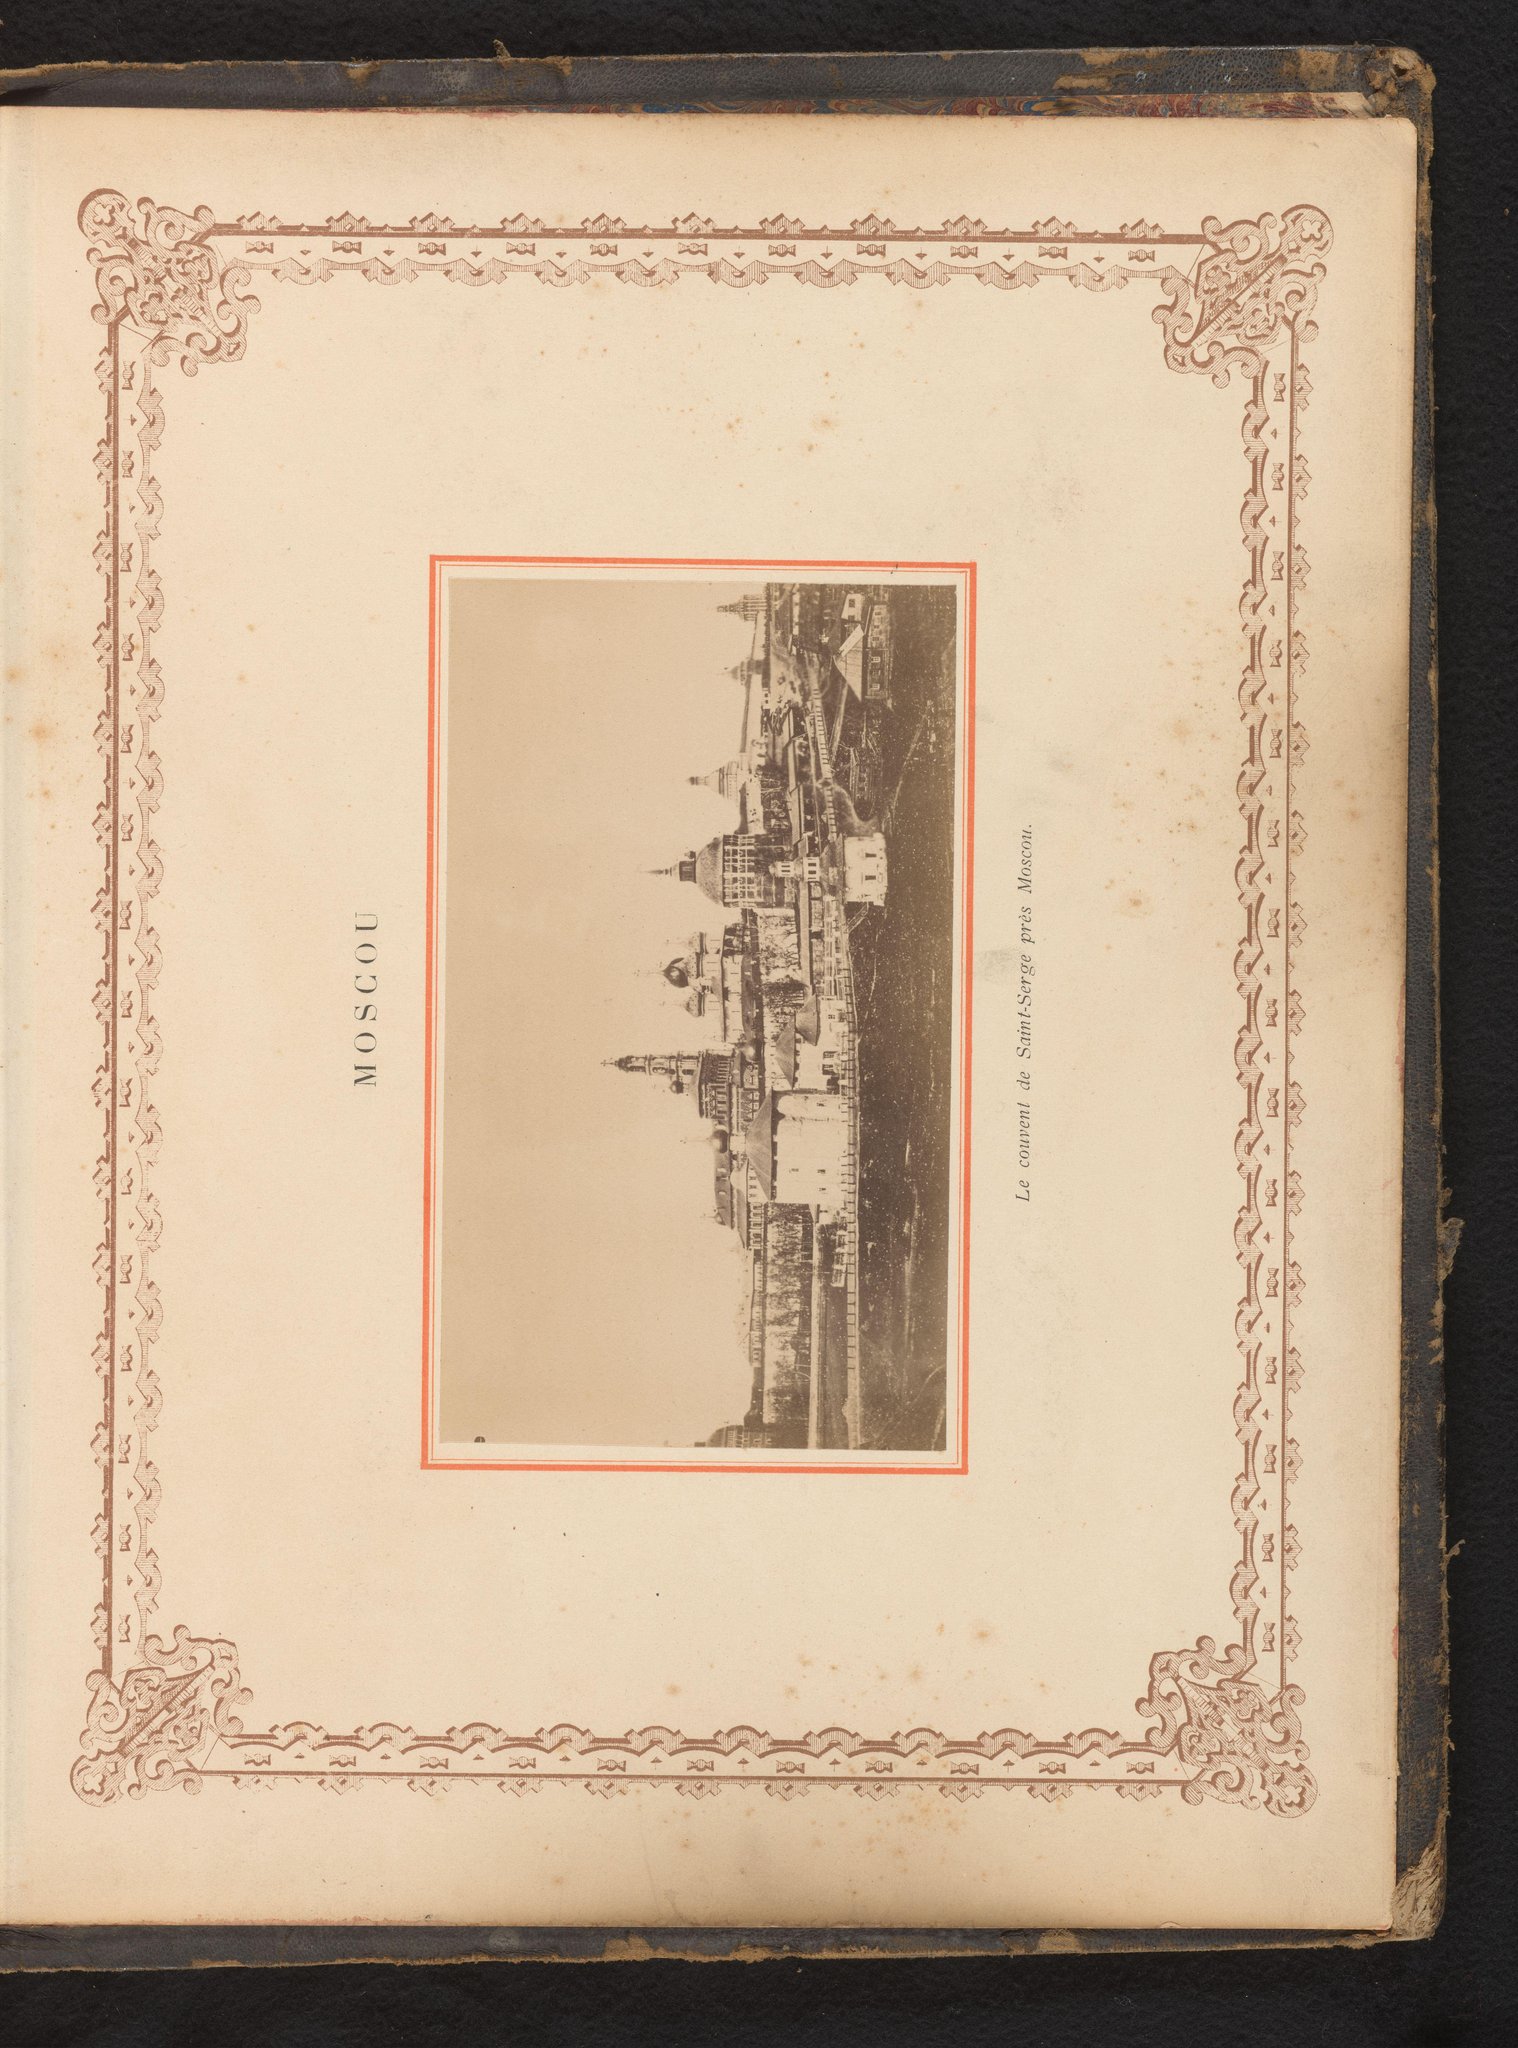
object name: page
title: Moscou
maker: Anonymous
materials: photographic support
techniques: albumen print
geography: zagorsk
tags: russian orthodox church, monastic orders, monastic life ~ roman catholic church